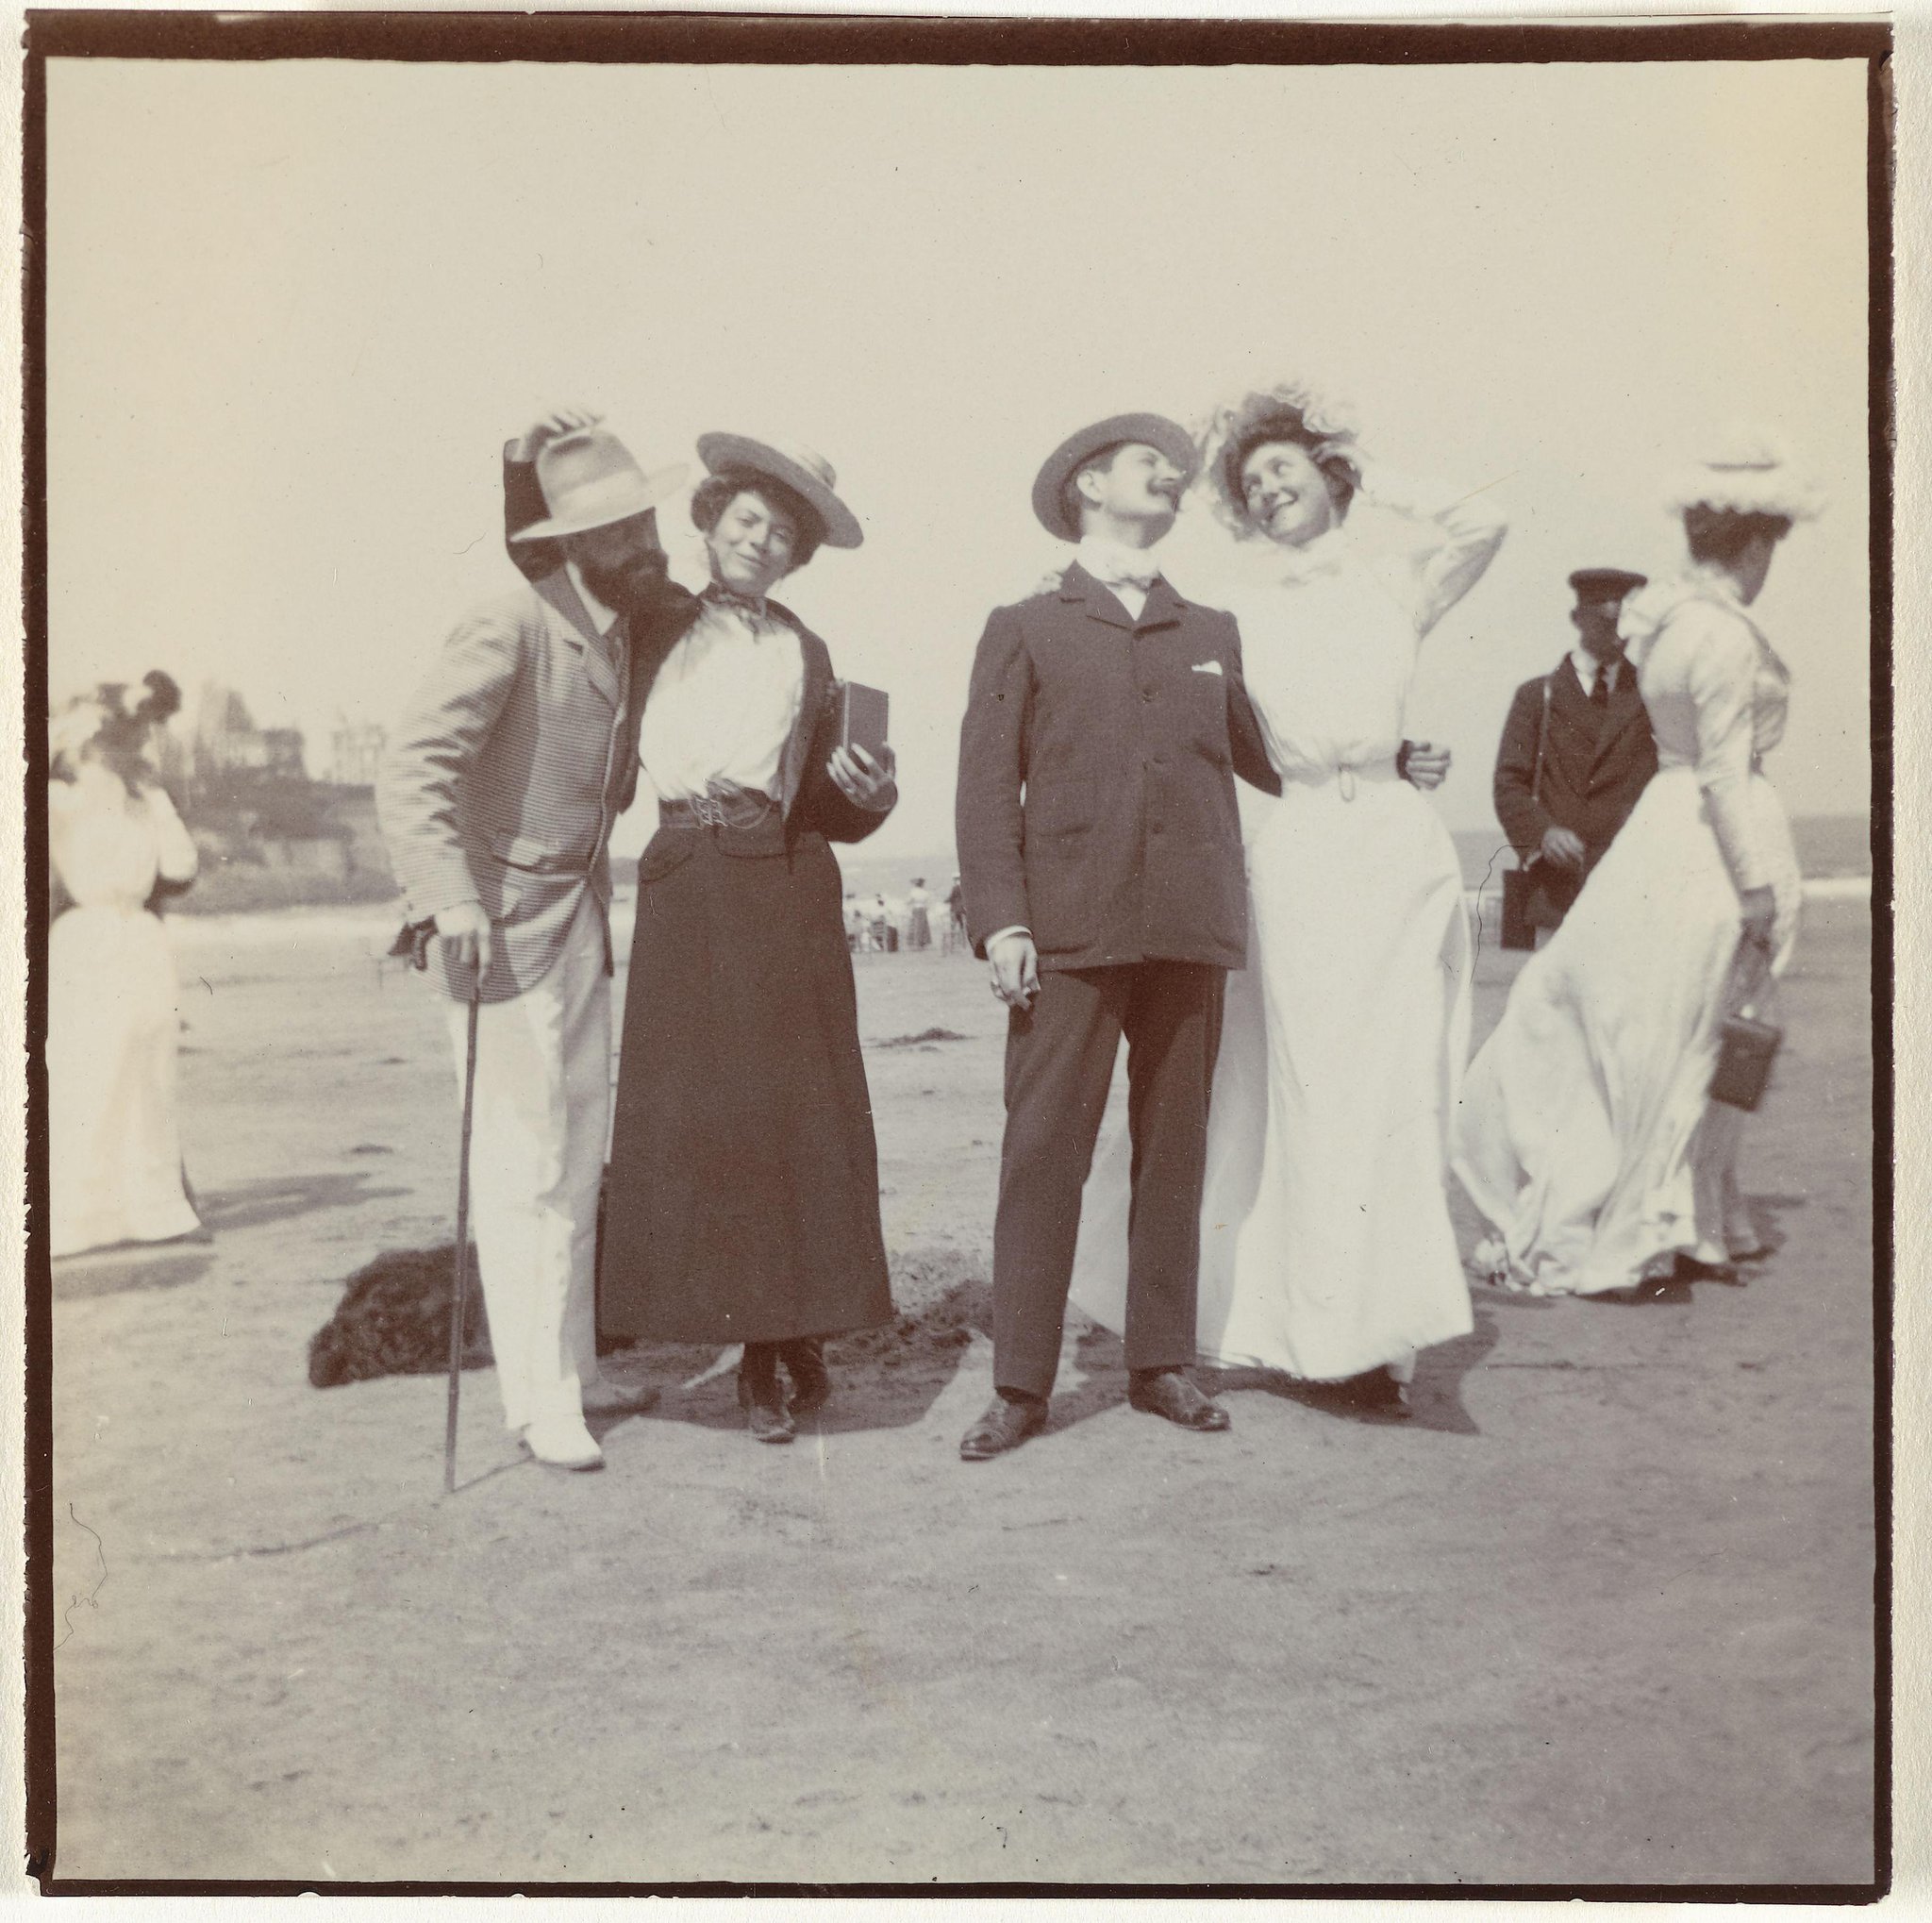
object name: photograph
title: Enthoven Girl with Friends on the Beach in Normandy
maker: Anonymous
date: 1900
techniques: photography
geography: normandy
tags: beach (as place of recreation)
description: Thanks to the handheld camera photography soon became the cheerful parlour game that we see in these Kodak photographs. Everyone on the beach is busy with their own camera and Enthoven’s Italian friends pose for and cavort with each other. One of the women holds a Pocket Kodak.